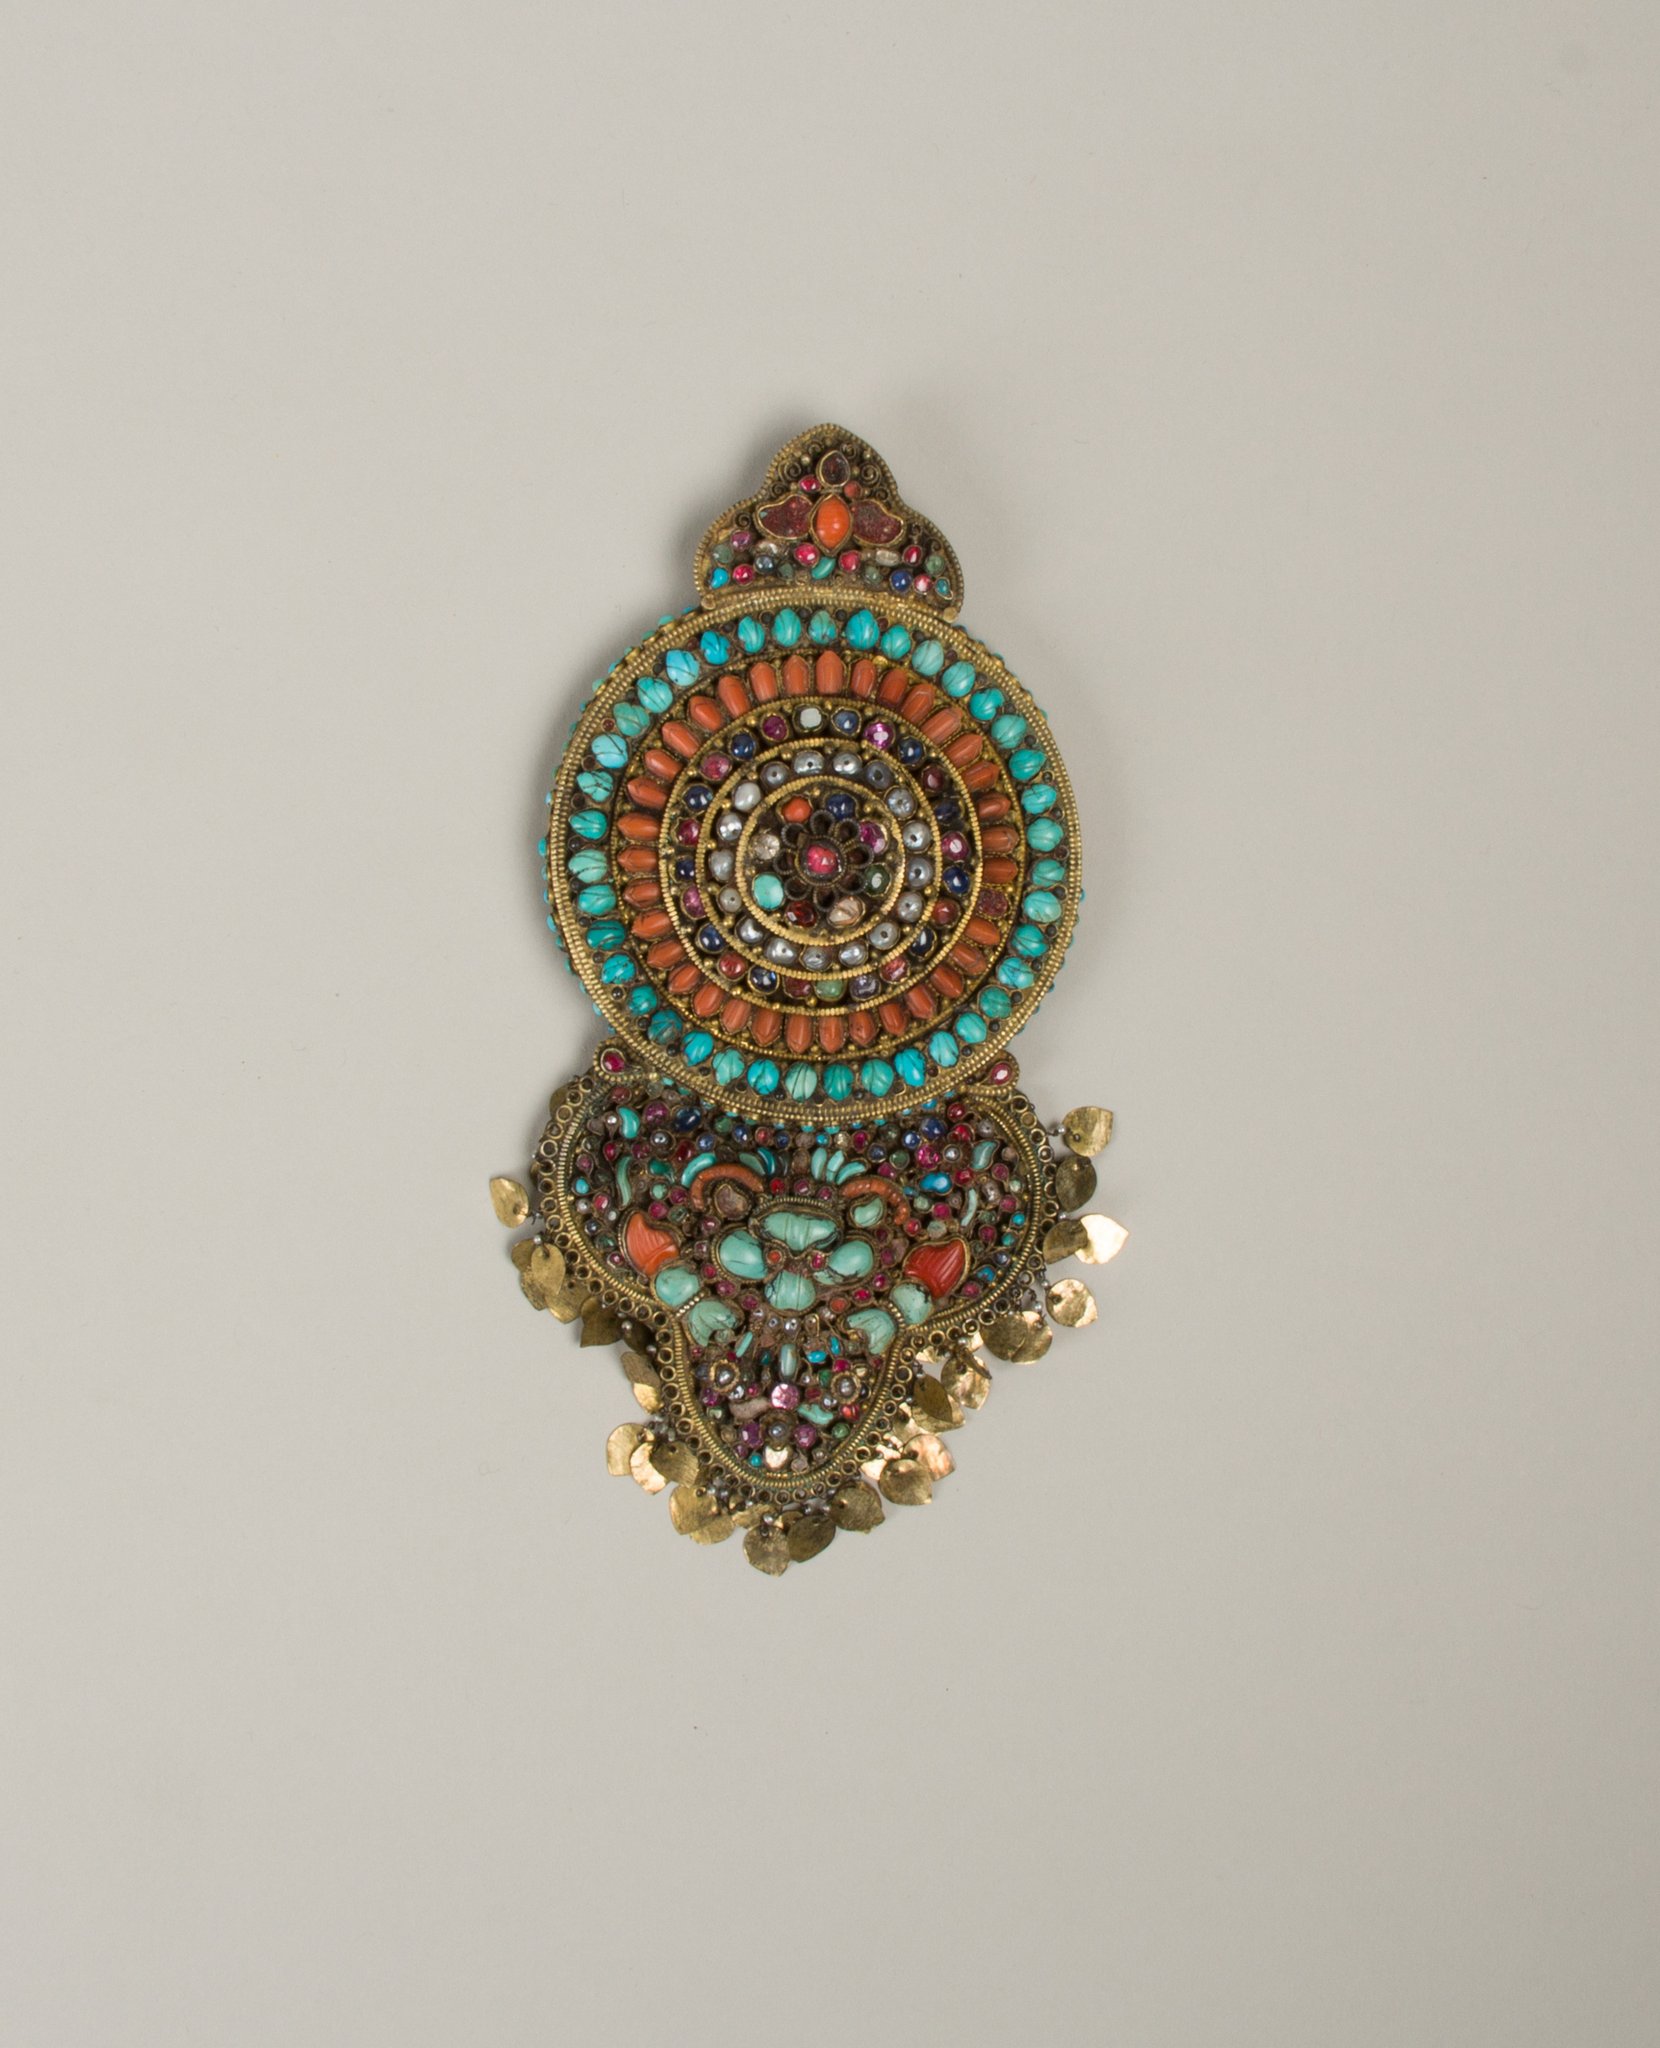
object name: earring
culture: tibetan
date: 1601-1900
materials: silver gilt, stone